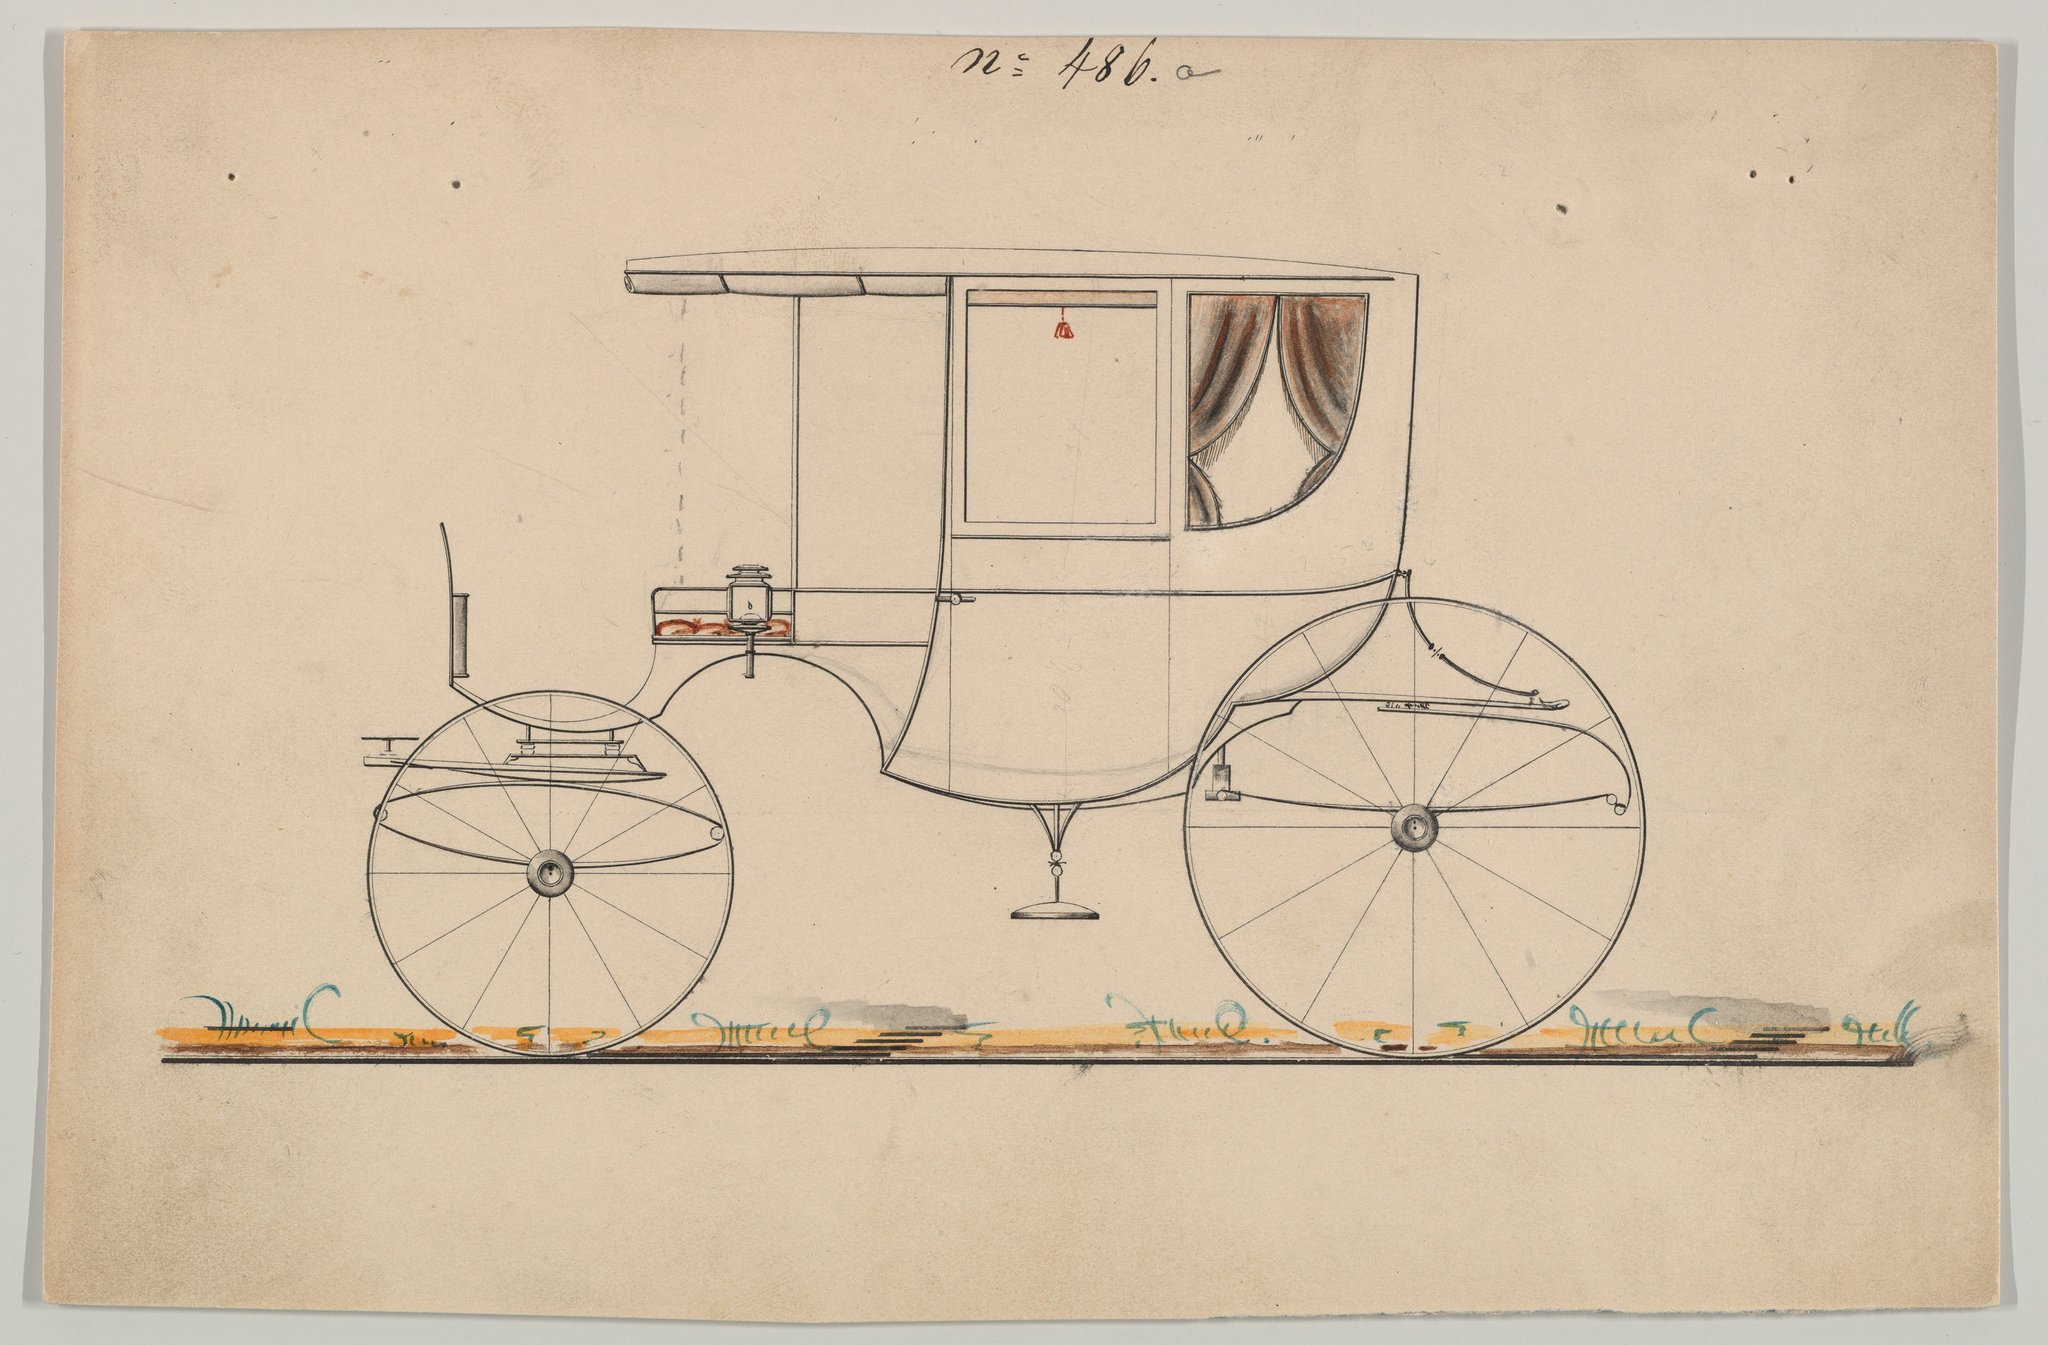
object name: drawing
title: Rockaway #486a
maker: brewster & co.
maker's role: manufacturer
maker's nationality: american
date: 1850-1870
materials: ink, watercolor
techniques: pen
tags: carriages